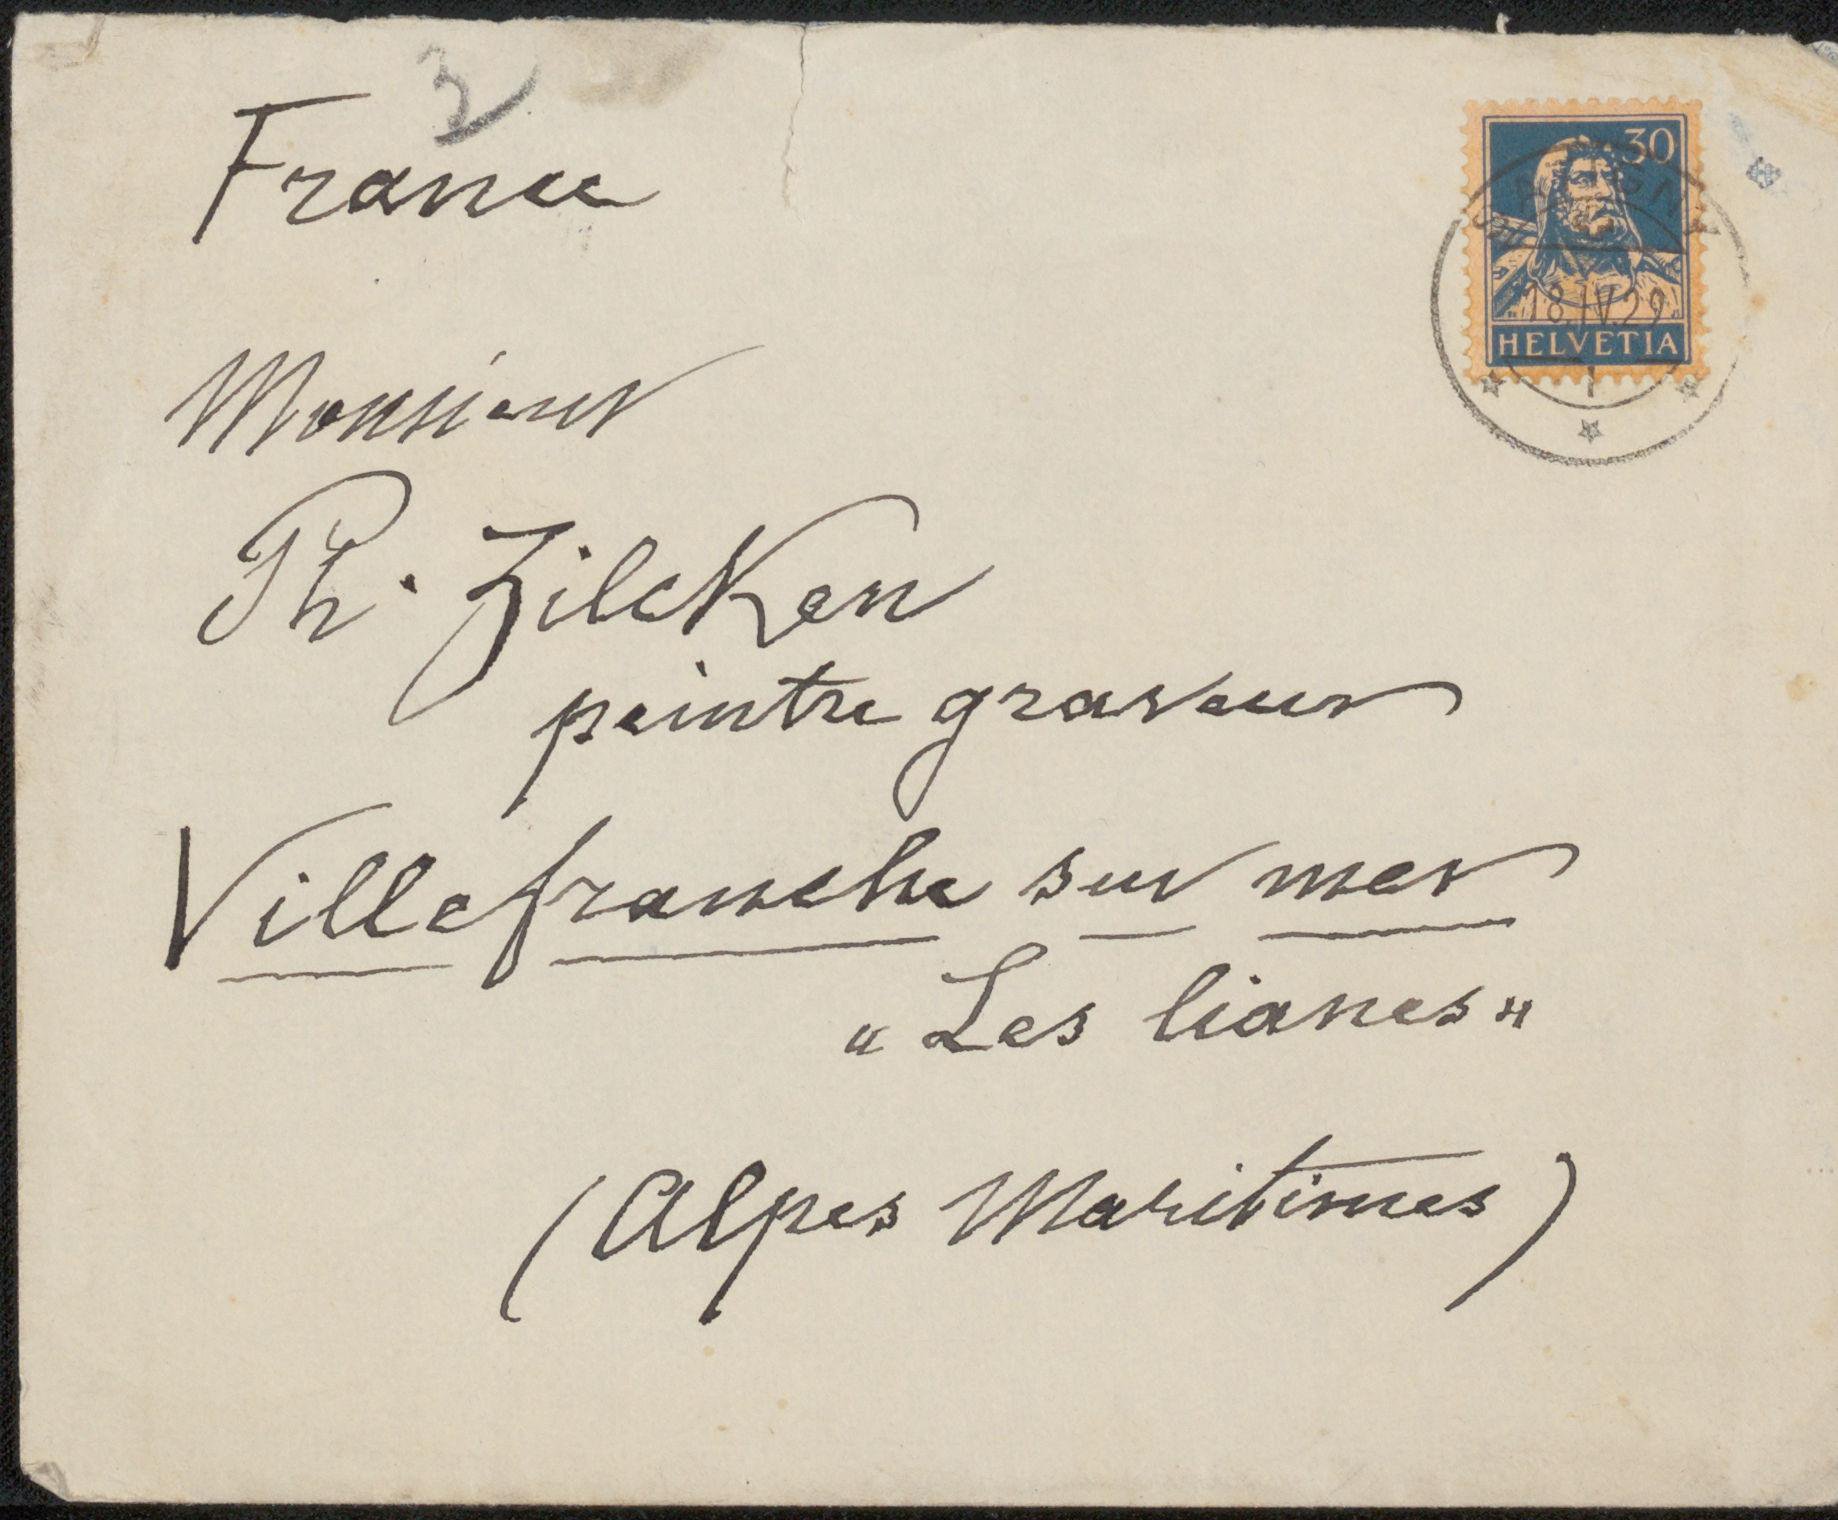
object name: envelope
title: Envelop aan Philip Zilcken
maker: alphonse stengelin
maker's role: painter, print maker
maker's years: 1852-1938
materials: ink, paper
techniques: pen, writing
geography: satigny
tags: the hague, painter, philip zilcken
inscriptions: collector's mark: ‘RPK’